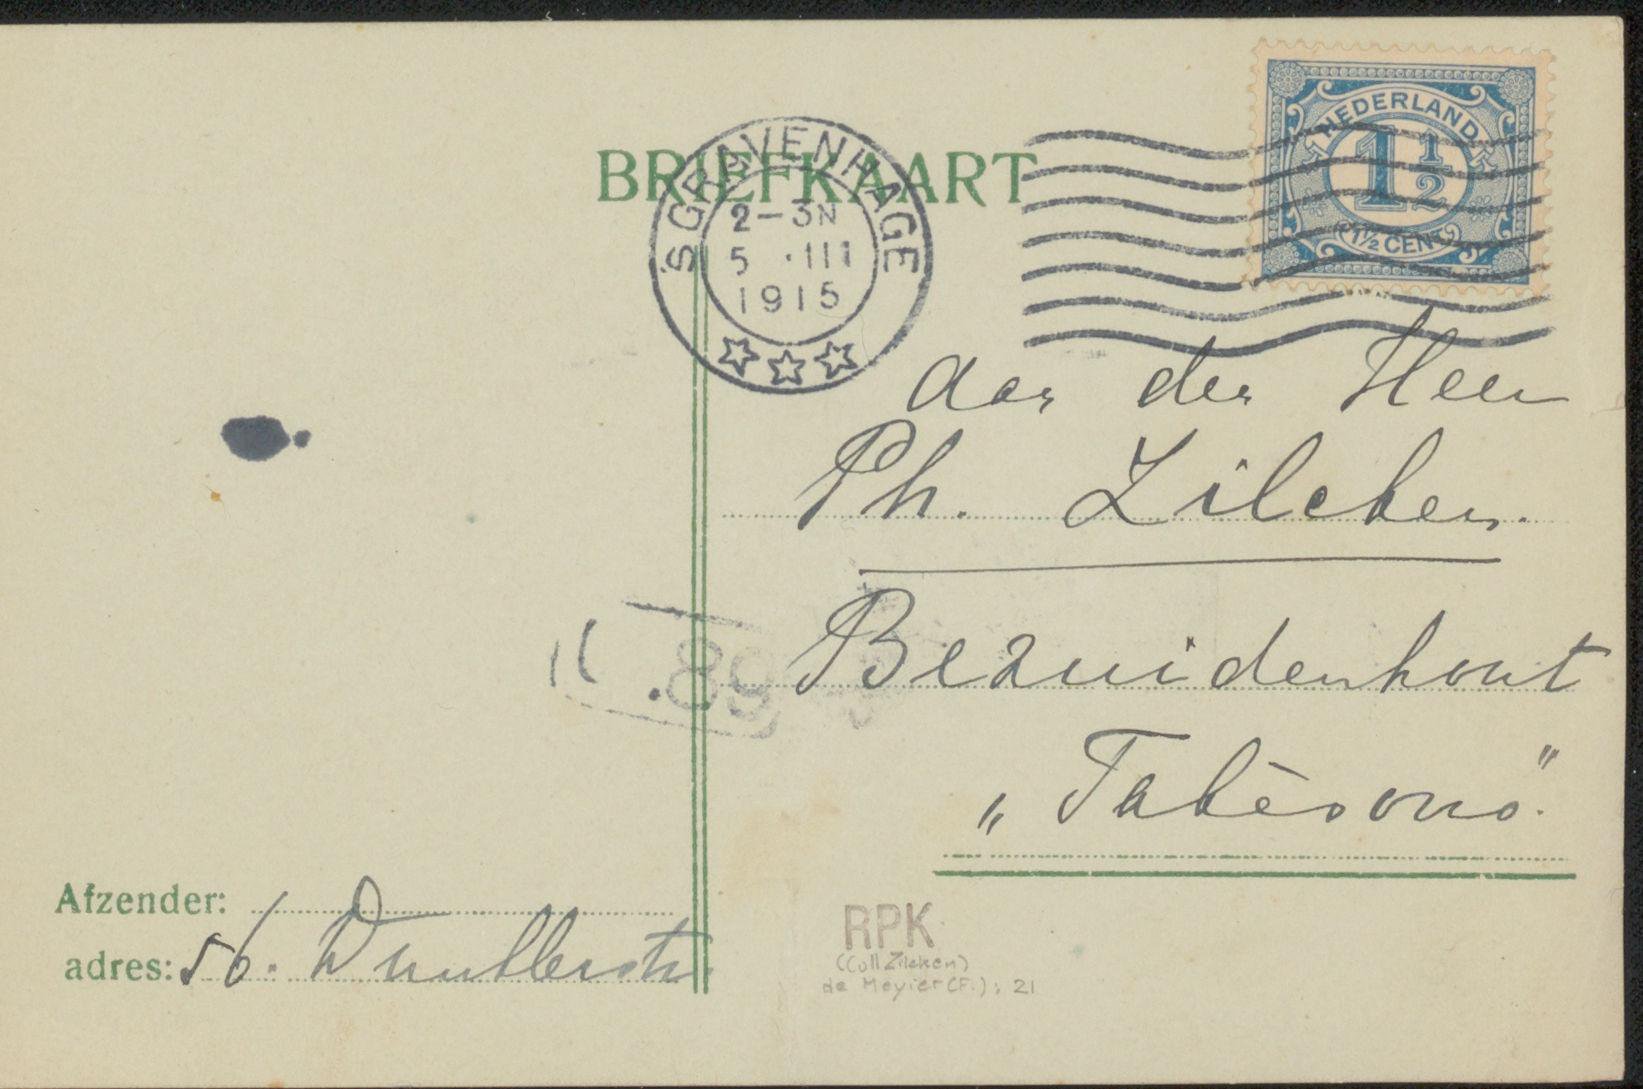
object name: postcard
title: Briefkaart aan Philip Zilcken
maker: fenna de meyier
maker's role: onderwijzer, schrijver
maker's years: 1874-1943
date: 1915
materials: cardboard, ink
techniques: pen, writing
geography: the hague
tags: louis couperus, the hague, draughtsman, philip zilcken, criticizing and discussing art, art criticism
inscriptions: collector's mark: ‘RPK’